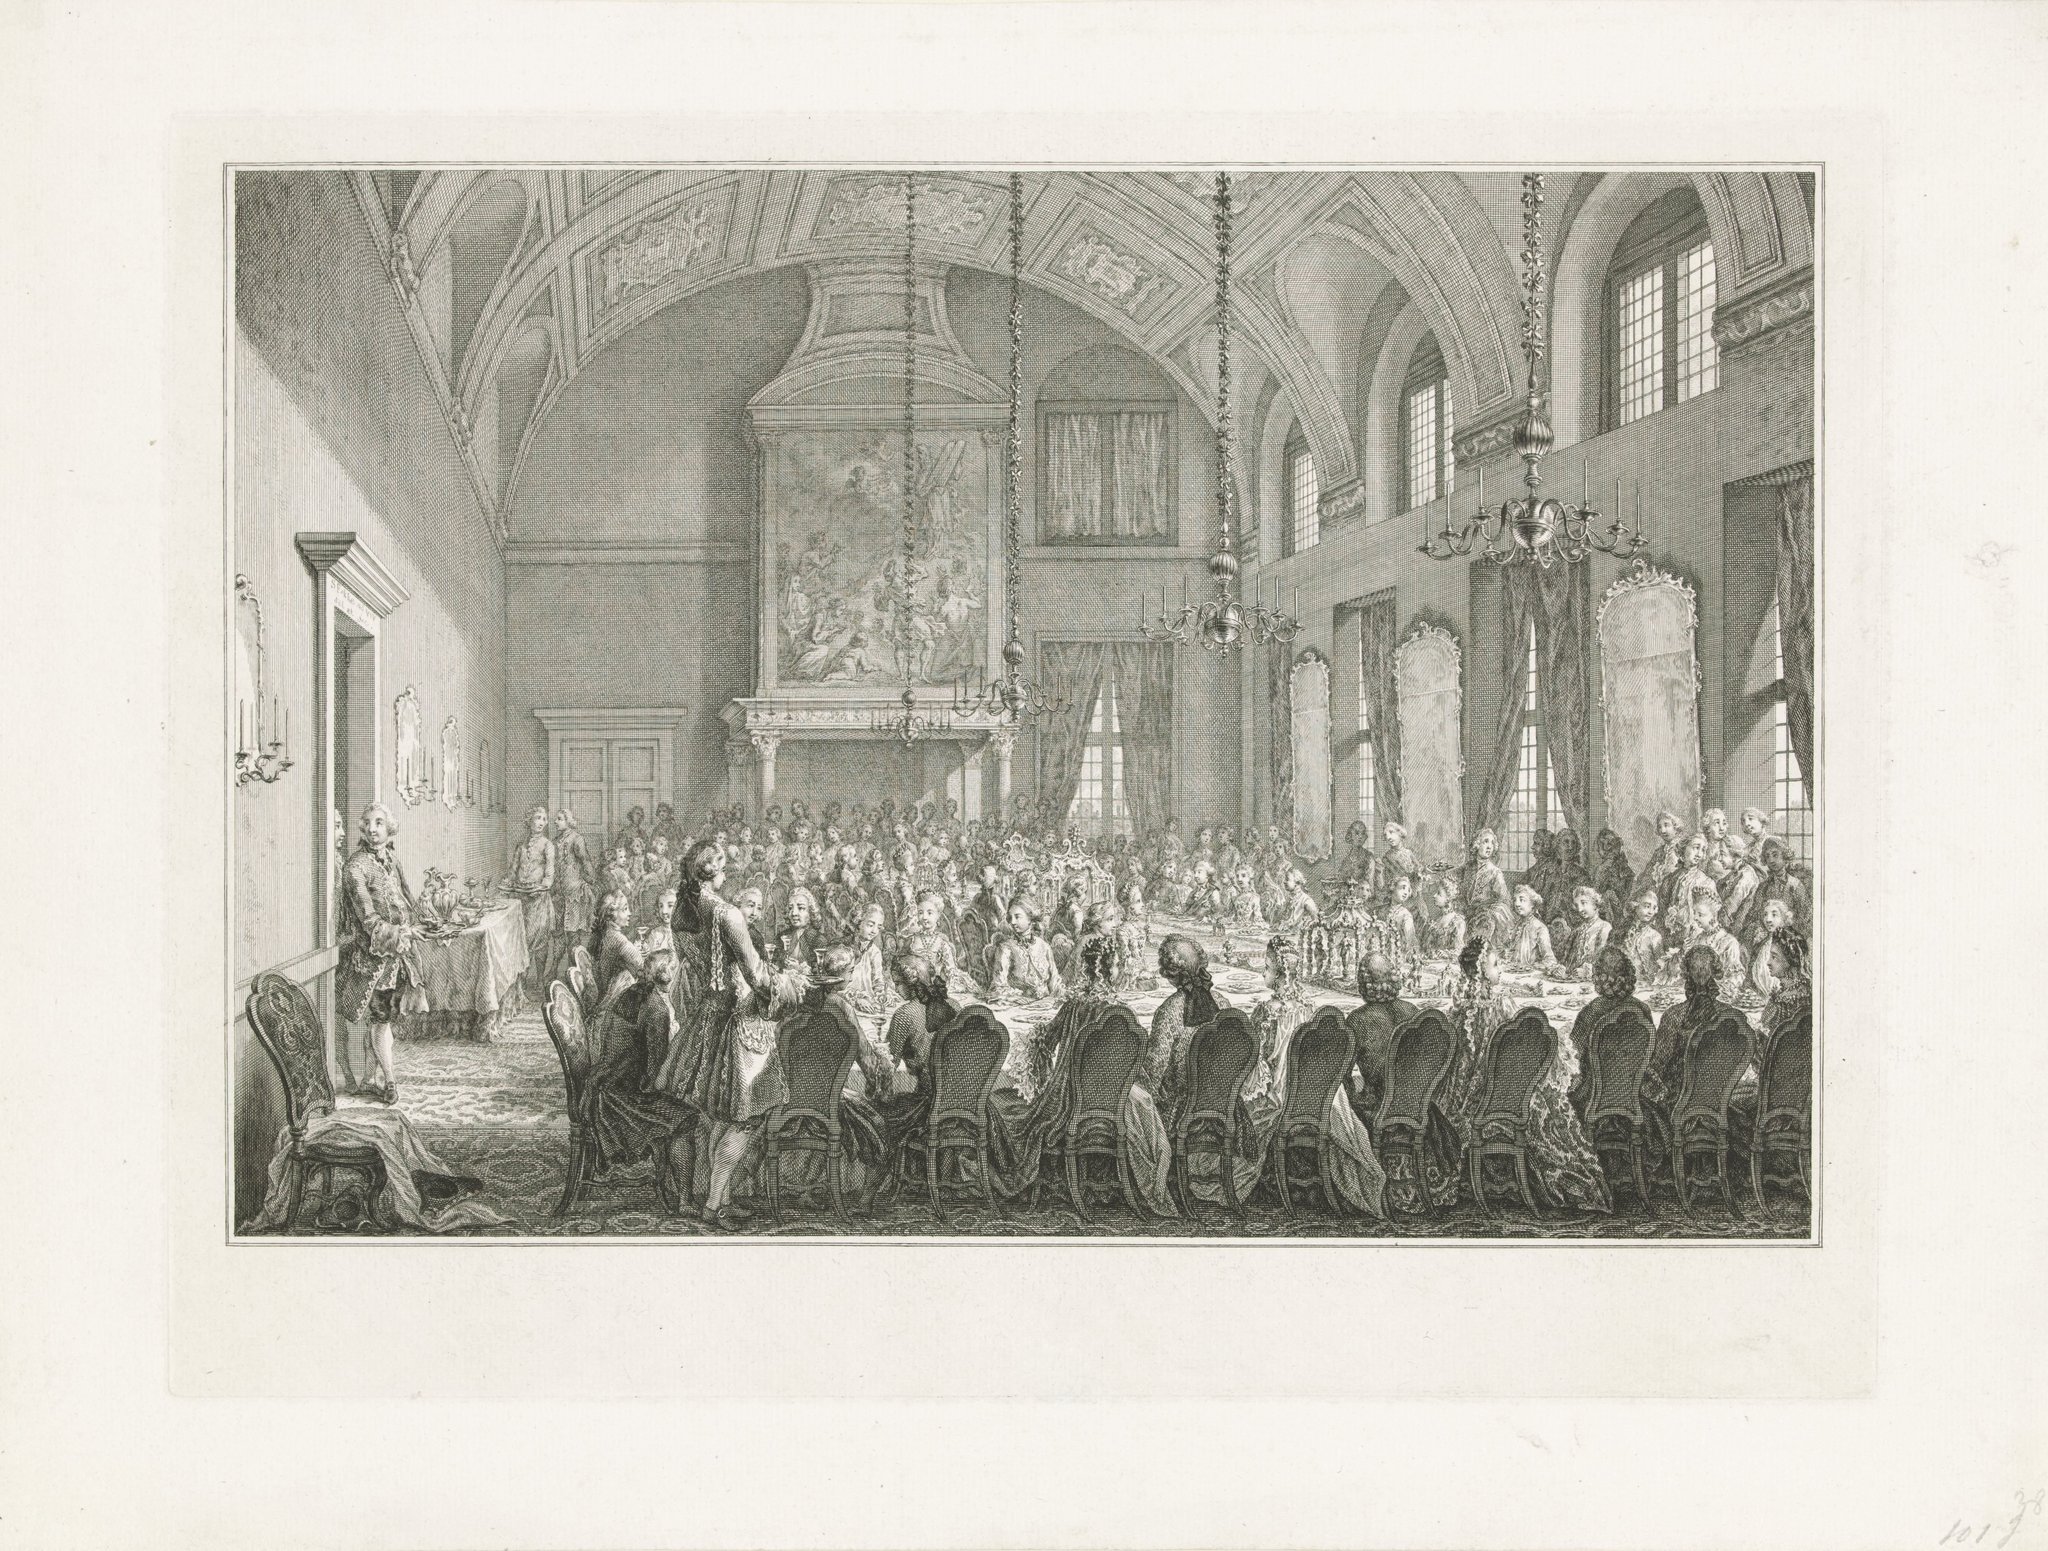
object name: print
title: Feestmaal in de Schepenkamer voor Willem V en Wilhelmina van Pruisen, 1768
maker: simon fokke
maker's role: draughtsman, print maker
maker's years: 1712-1784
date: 1772-1773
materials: paper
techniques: engraving, etching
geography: northern netherlands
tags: the hague, william v (prince of orange), berlin, painter, wilhelmina of prussia (princess of orange), public festivities on the occasion of royal events (+ eating and drinking ~ festive activities), celebration meal, feast, banquet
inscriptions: collector's mark: Lugt 2228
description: Feestmaal aangeboden door het stadsbestuur van Amsterdam aan stadhouder Willem V en prinses Wilhelmina van Pruisen, in de Schepenkamer in het Stadhuis, 1 juni 1768. Onderdeel van een prentserie met titelprent en 14 platen van de inhaling van de prins en prinses te Amsterdam, 30 mei - 4 juni 1768.